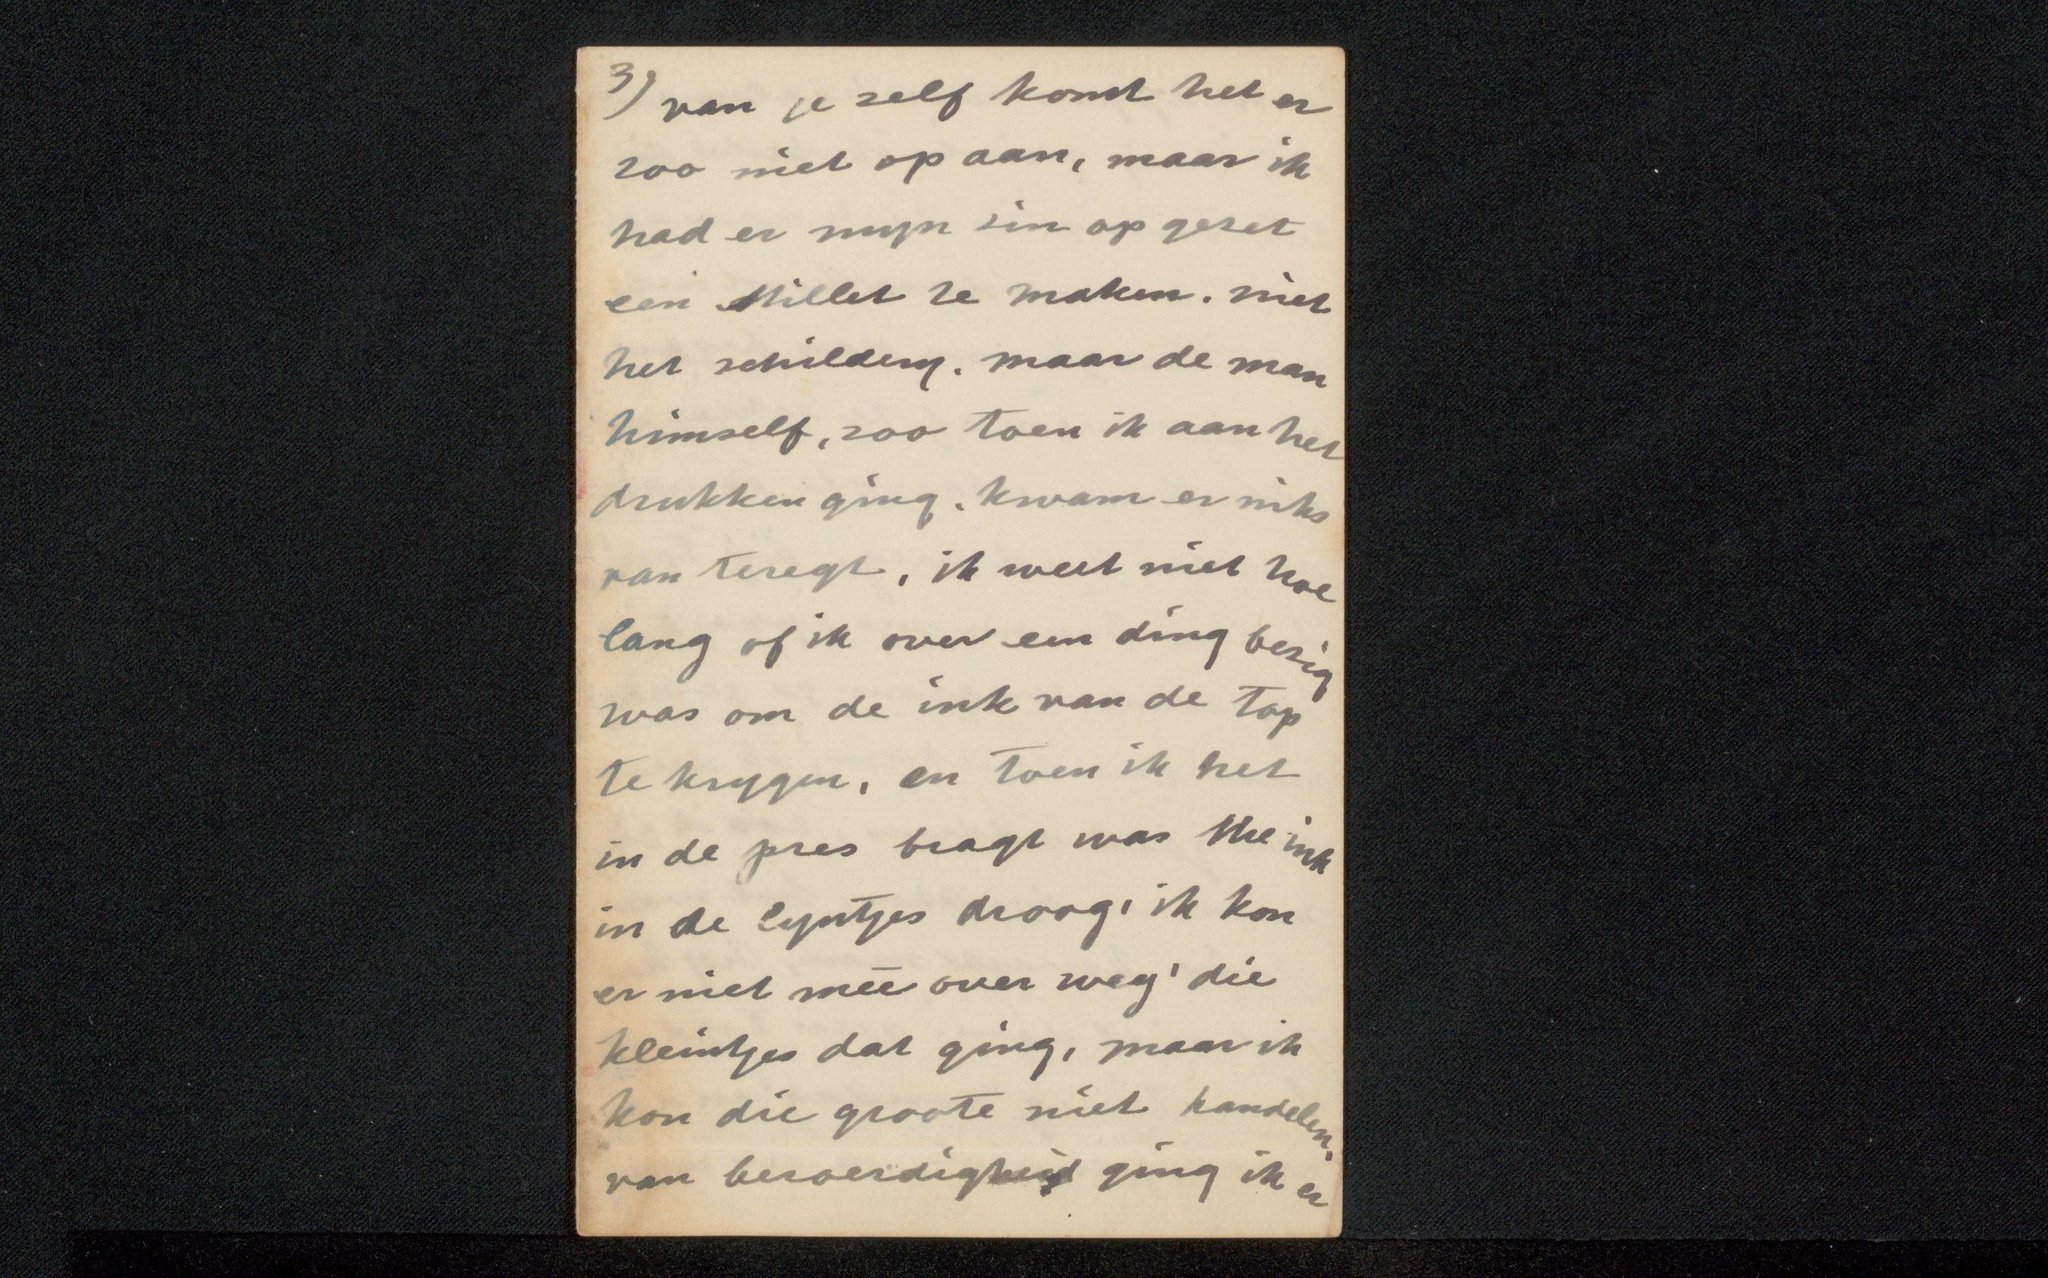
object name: letter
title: Brief aan Philip Zilcken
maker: matthijs maris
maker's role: draughtsman, painter, print maker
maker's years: 1839-1917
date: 1892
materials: ink, paper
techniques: pen, writing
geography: london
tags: john macallan swan, painter, print maker, draughtsman, jean françois millet, philip zilcken, the graphic arts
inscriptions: watermark, collector's mark: ‘RPK’